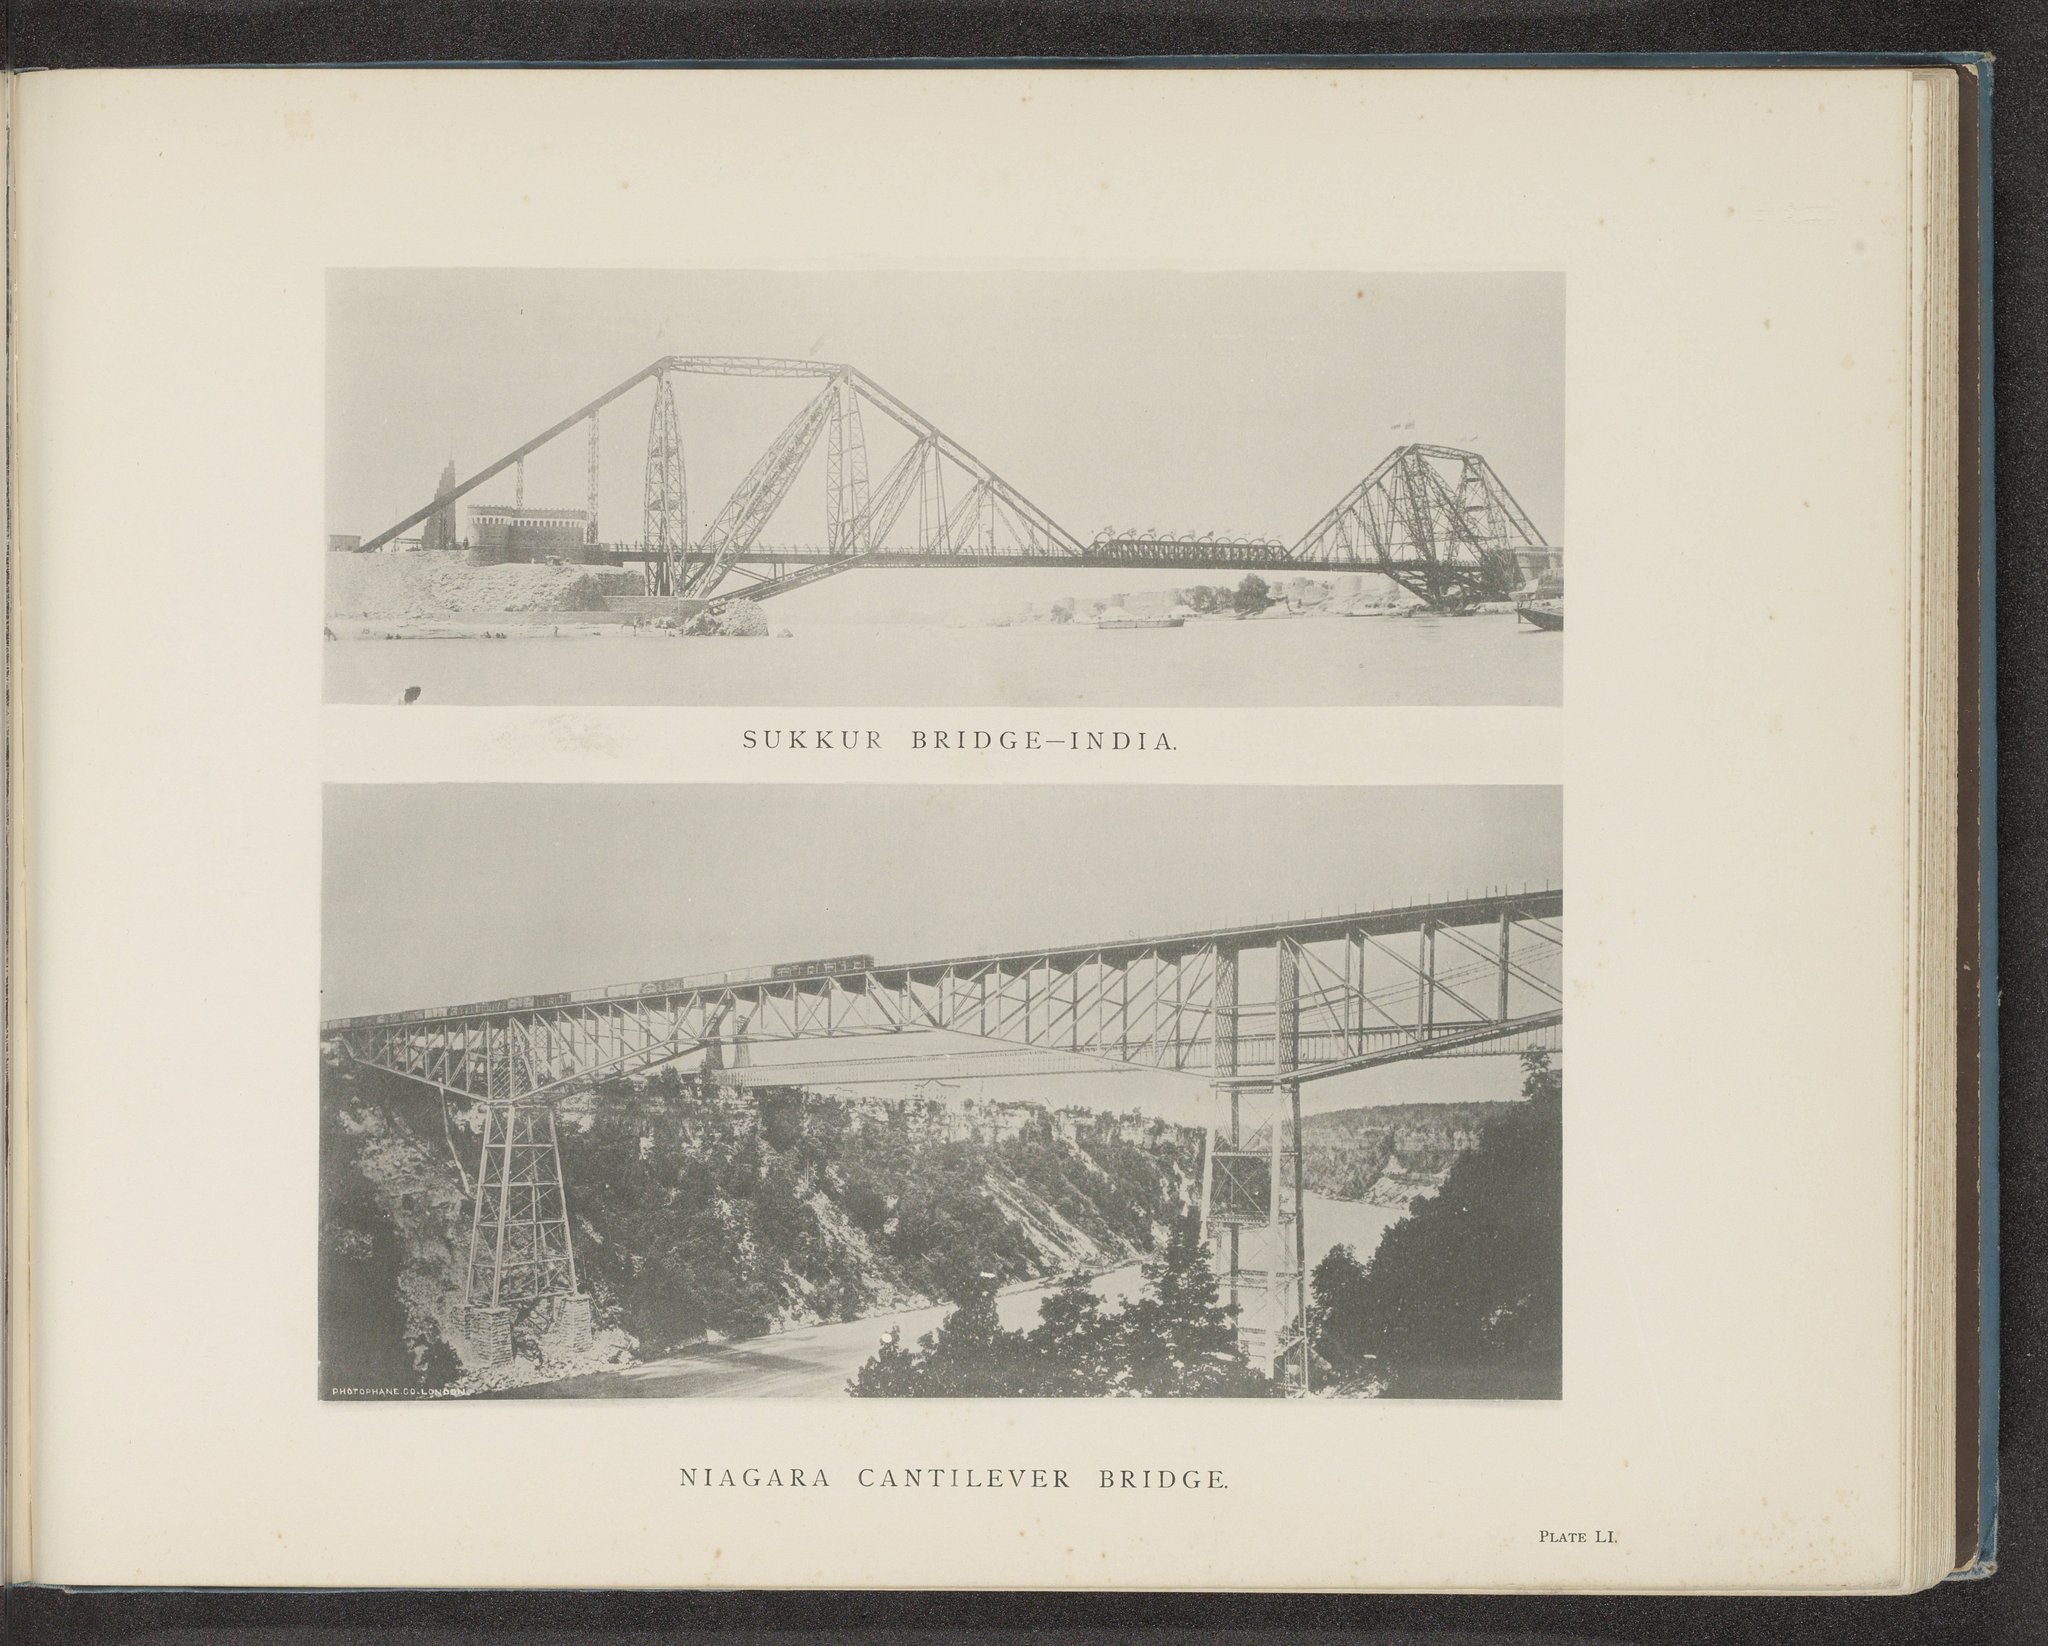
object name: page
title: Sukkur Bridge-India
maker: Anonymous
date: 1880-1890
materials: paper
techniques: photograph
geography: london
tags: landscape with bridge, viaduct or aqueduct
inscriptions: number: ‘Plate LI.’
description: Boven de Lansdowne bridge rohri en onder de Niagara cantilever bridge.